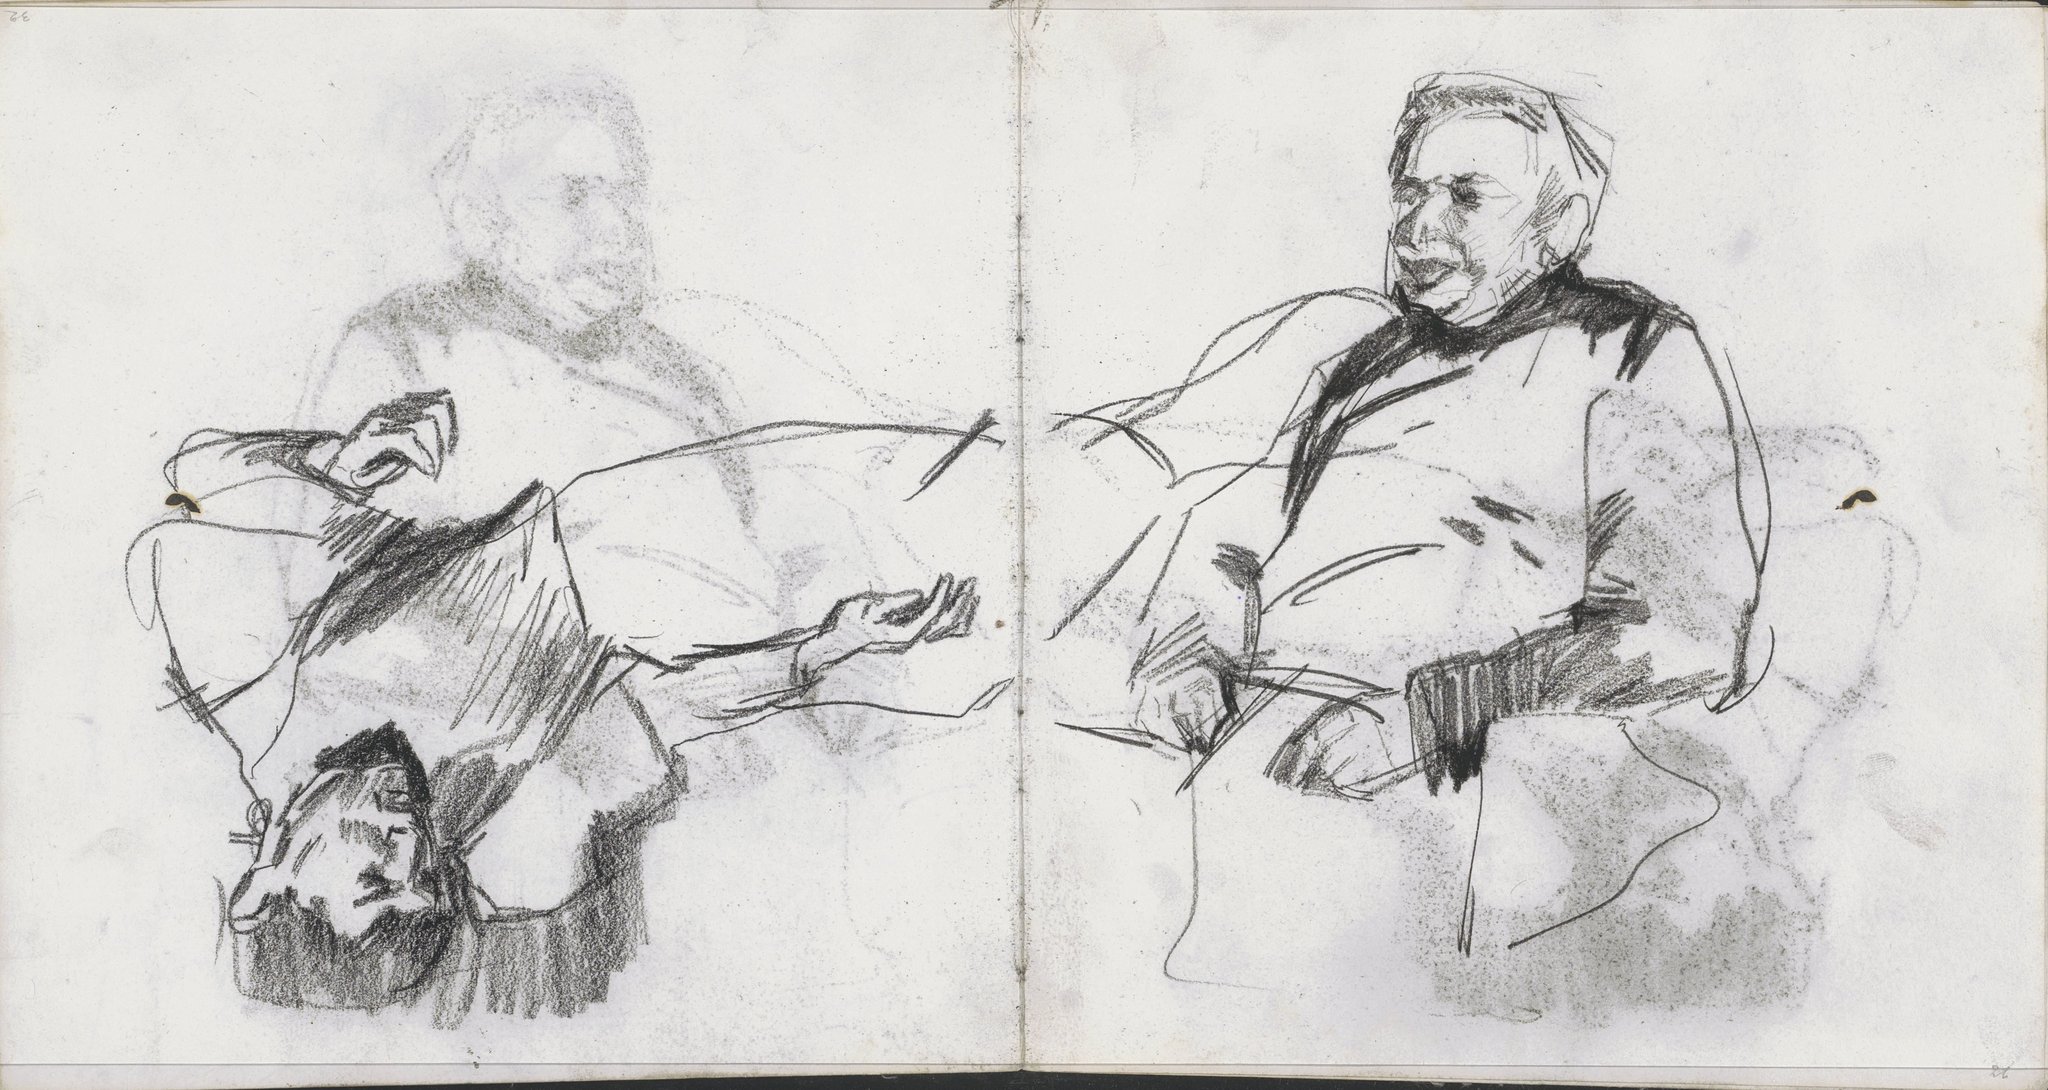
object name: sketchbook leaf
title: Liggende figuur en een zittende man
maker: isaac israels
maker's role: draughtsman, painter, print maker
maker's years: 1865-1934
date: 1875-1934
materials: chalk, paper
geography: the hague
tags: lying figure, old man (+ sitting)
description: Blad 25 verso en blad 26 recto uit schetsboek IX met 28 bladen.